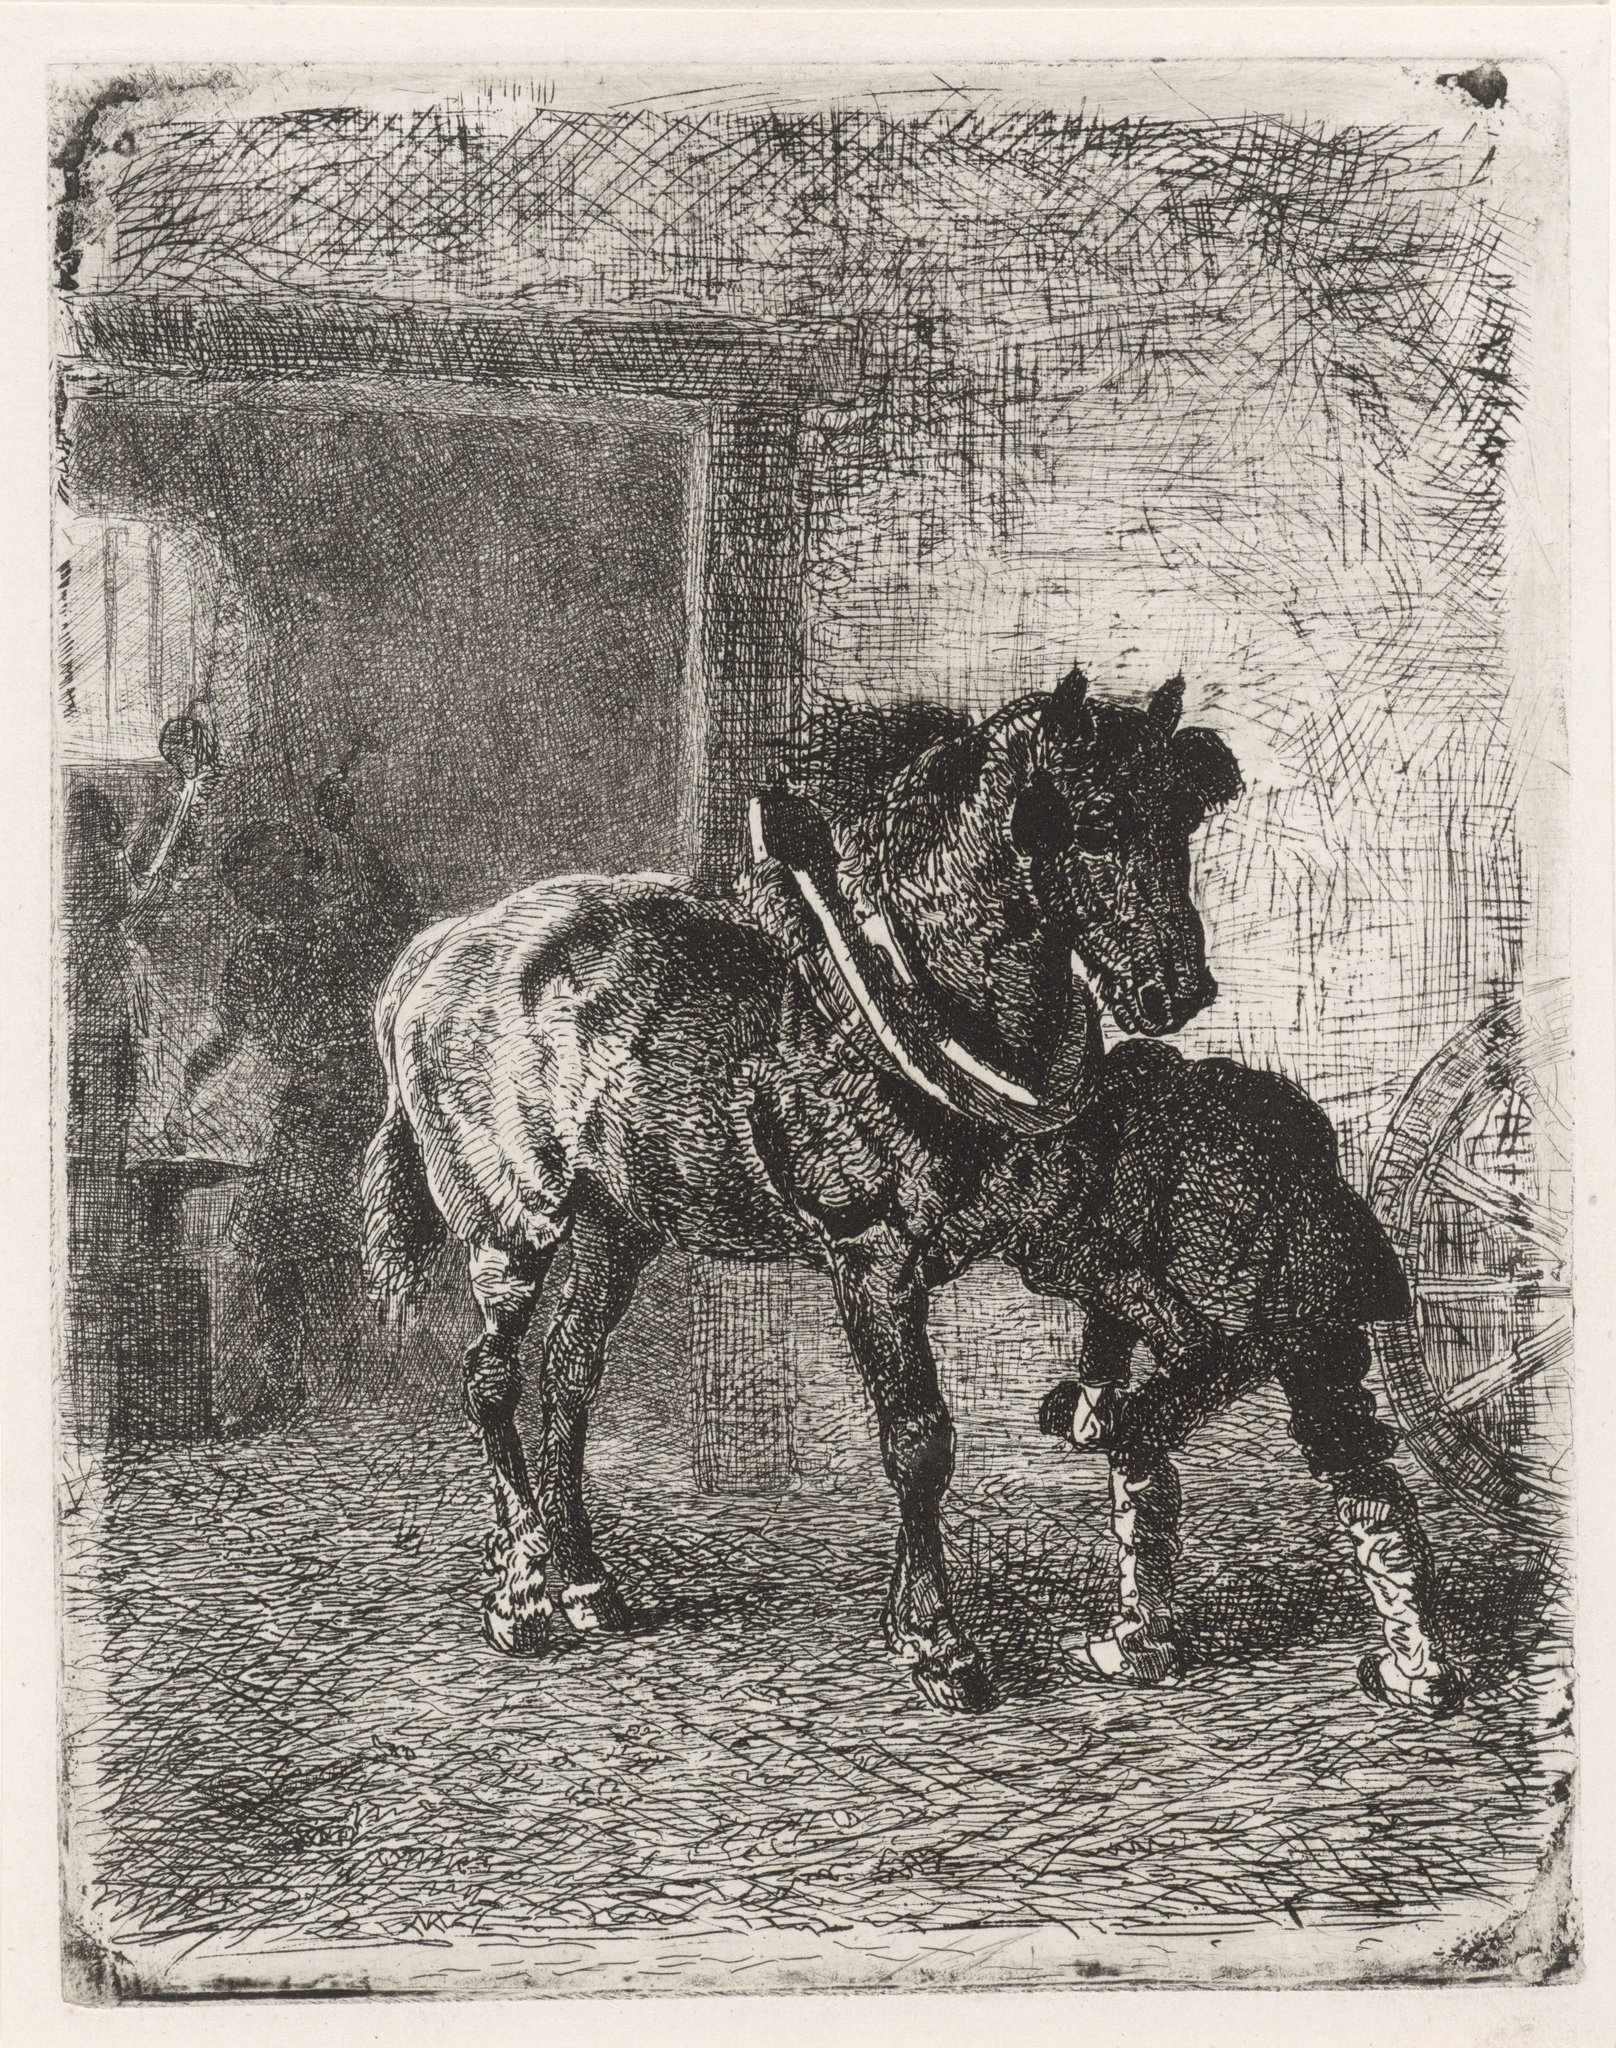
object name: print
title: Paard krijgt hoefijzers in een smederij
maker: cornelis albertus johannes schermer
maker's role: draughtsman, painter, print maker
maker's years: 1824-1915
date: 1839-1915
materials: paper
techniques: etching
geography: the hague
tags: farrier, shoeing-smith, horse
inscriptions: collector's mark: Lugt 2228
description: Vooraan beslaat een man de hoef van een paard. Achter hem is een smid in een smederij aan het werk bij een aambeeld.